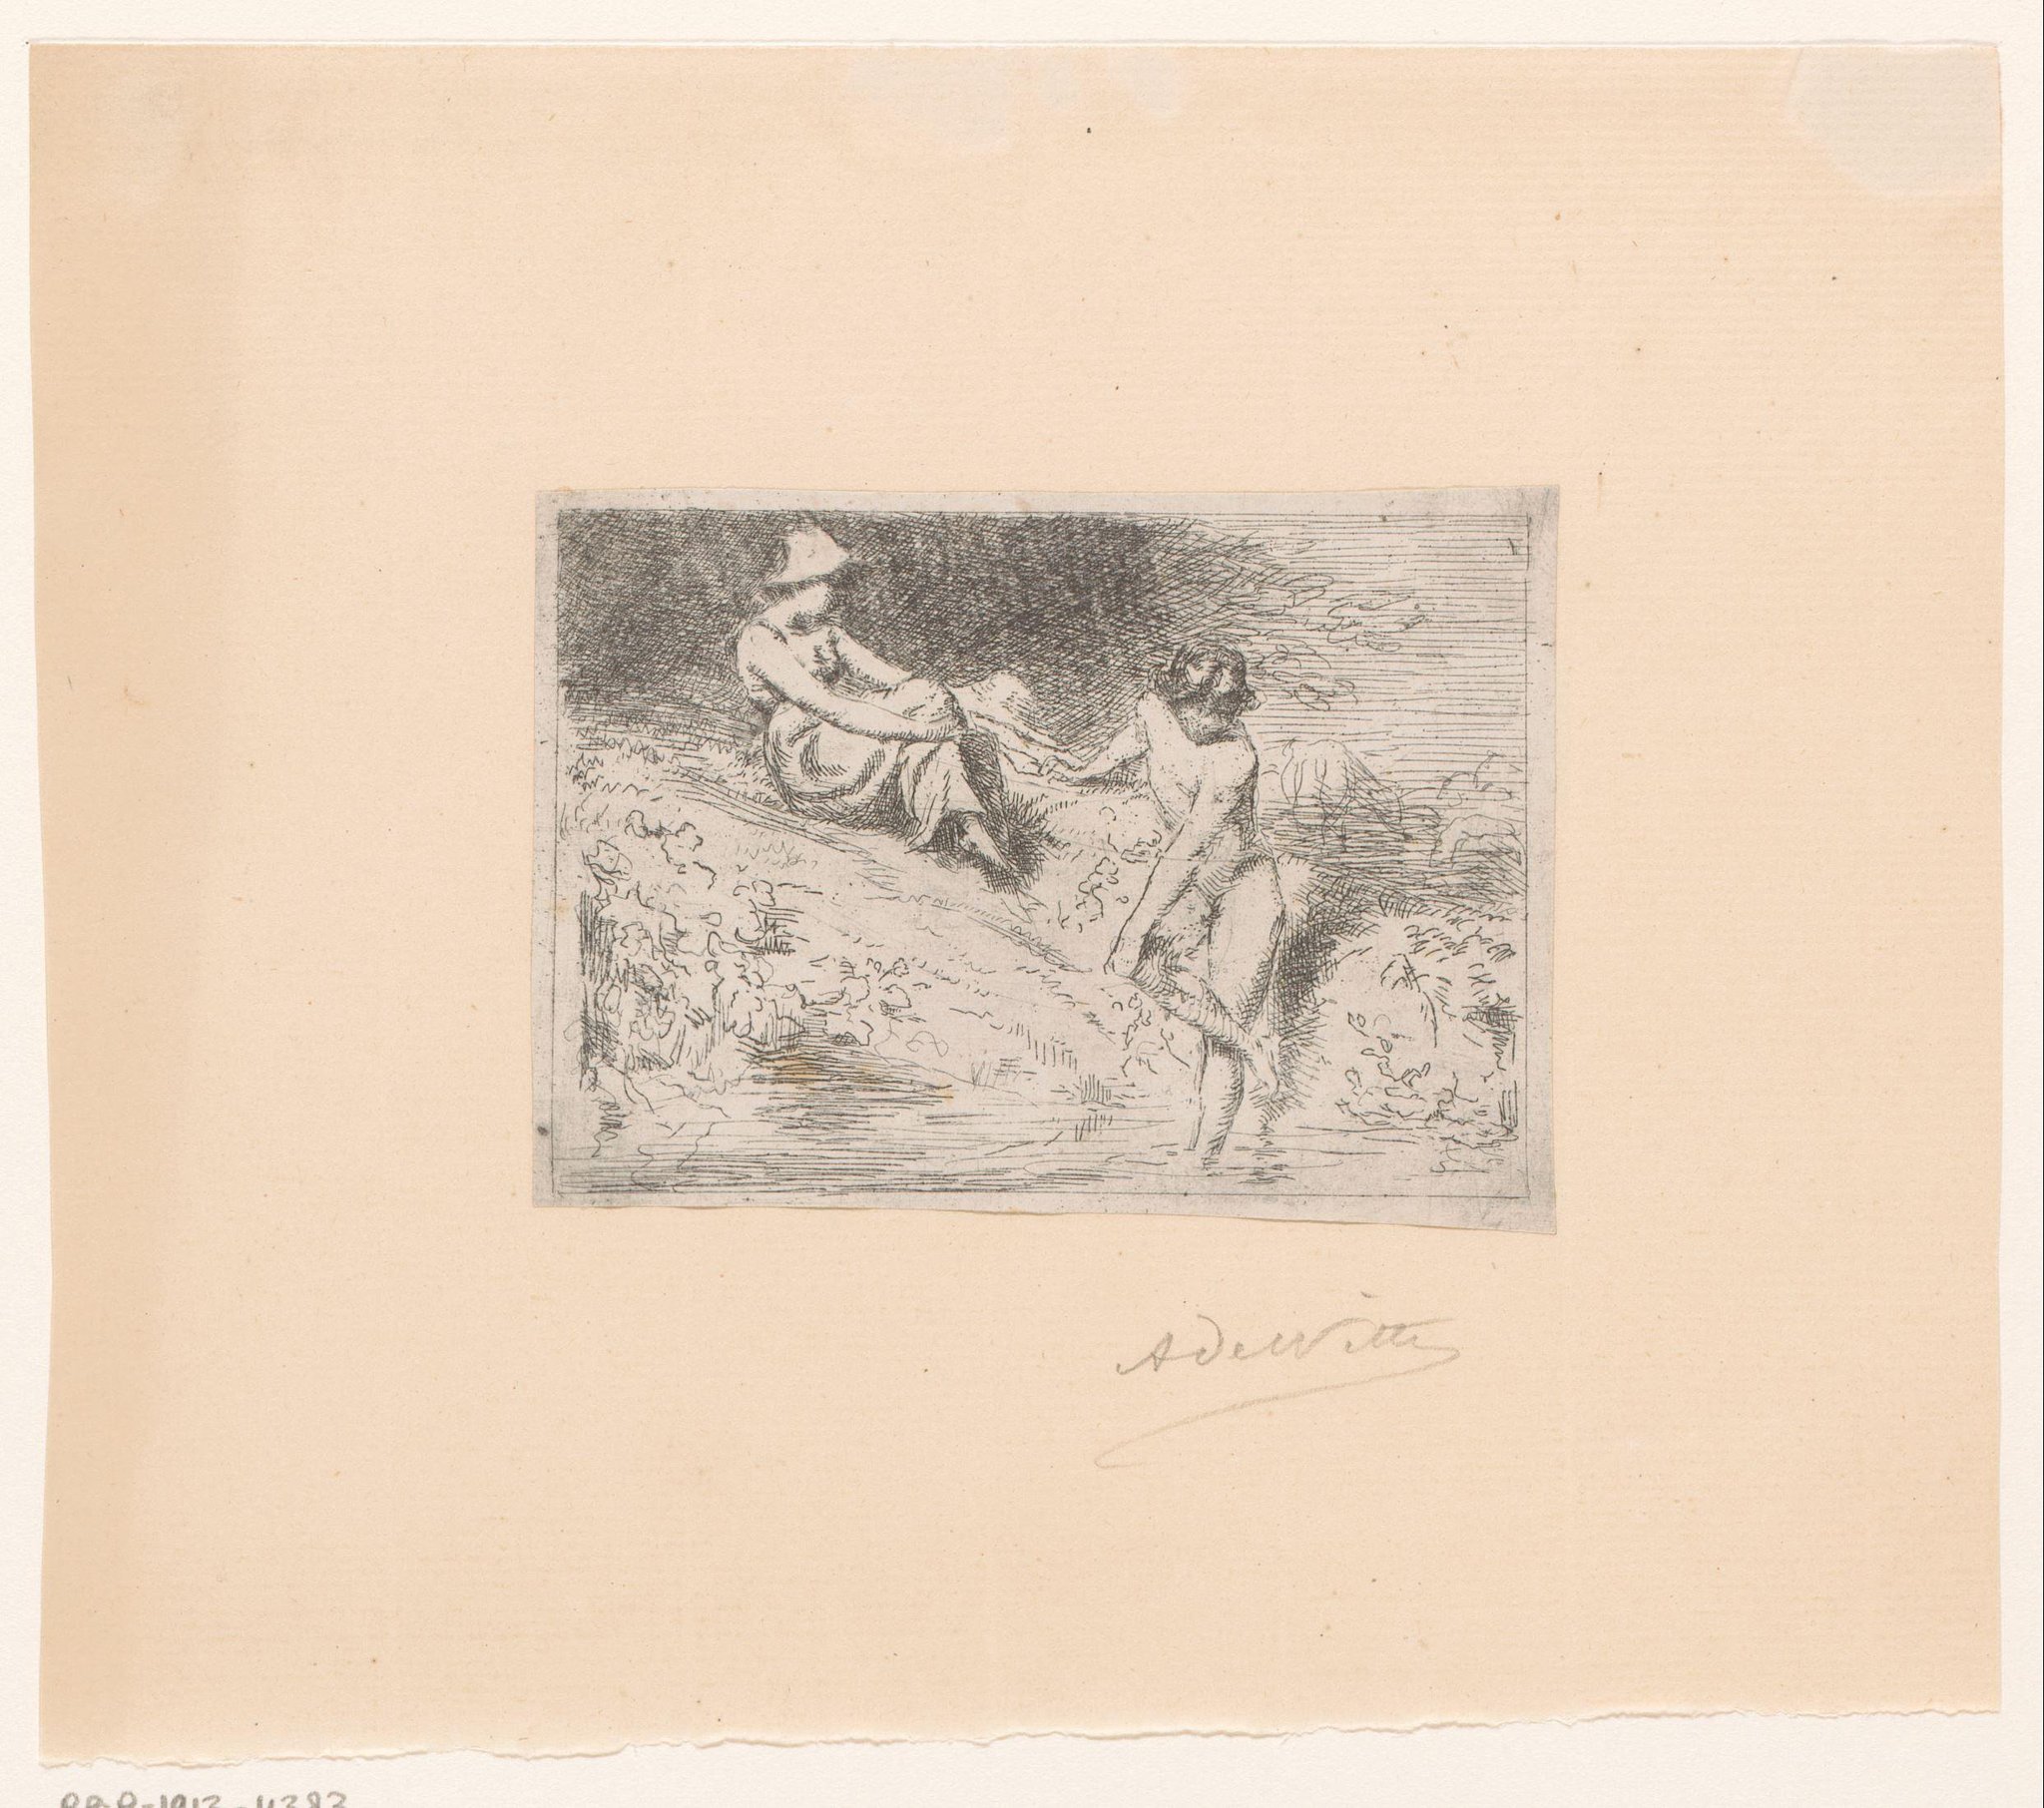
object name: print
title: Twee badende vrouwen aan de oever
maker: adrien de witte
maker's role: print maker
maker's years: 1850-1935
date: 1860-1913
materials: paper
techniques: etching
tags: taking a bath - aa - in the open air, adult woman (+ two persons), the (nude) human figure; 'corpo humano' (ripa) - aa - female human figure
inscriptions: collector's mark: Lugt 2228